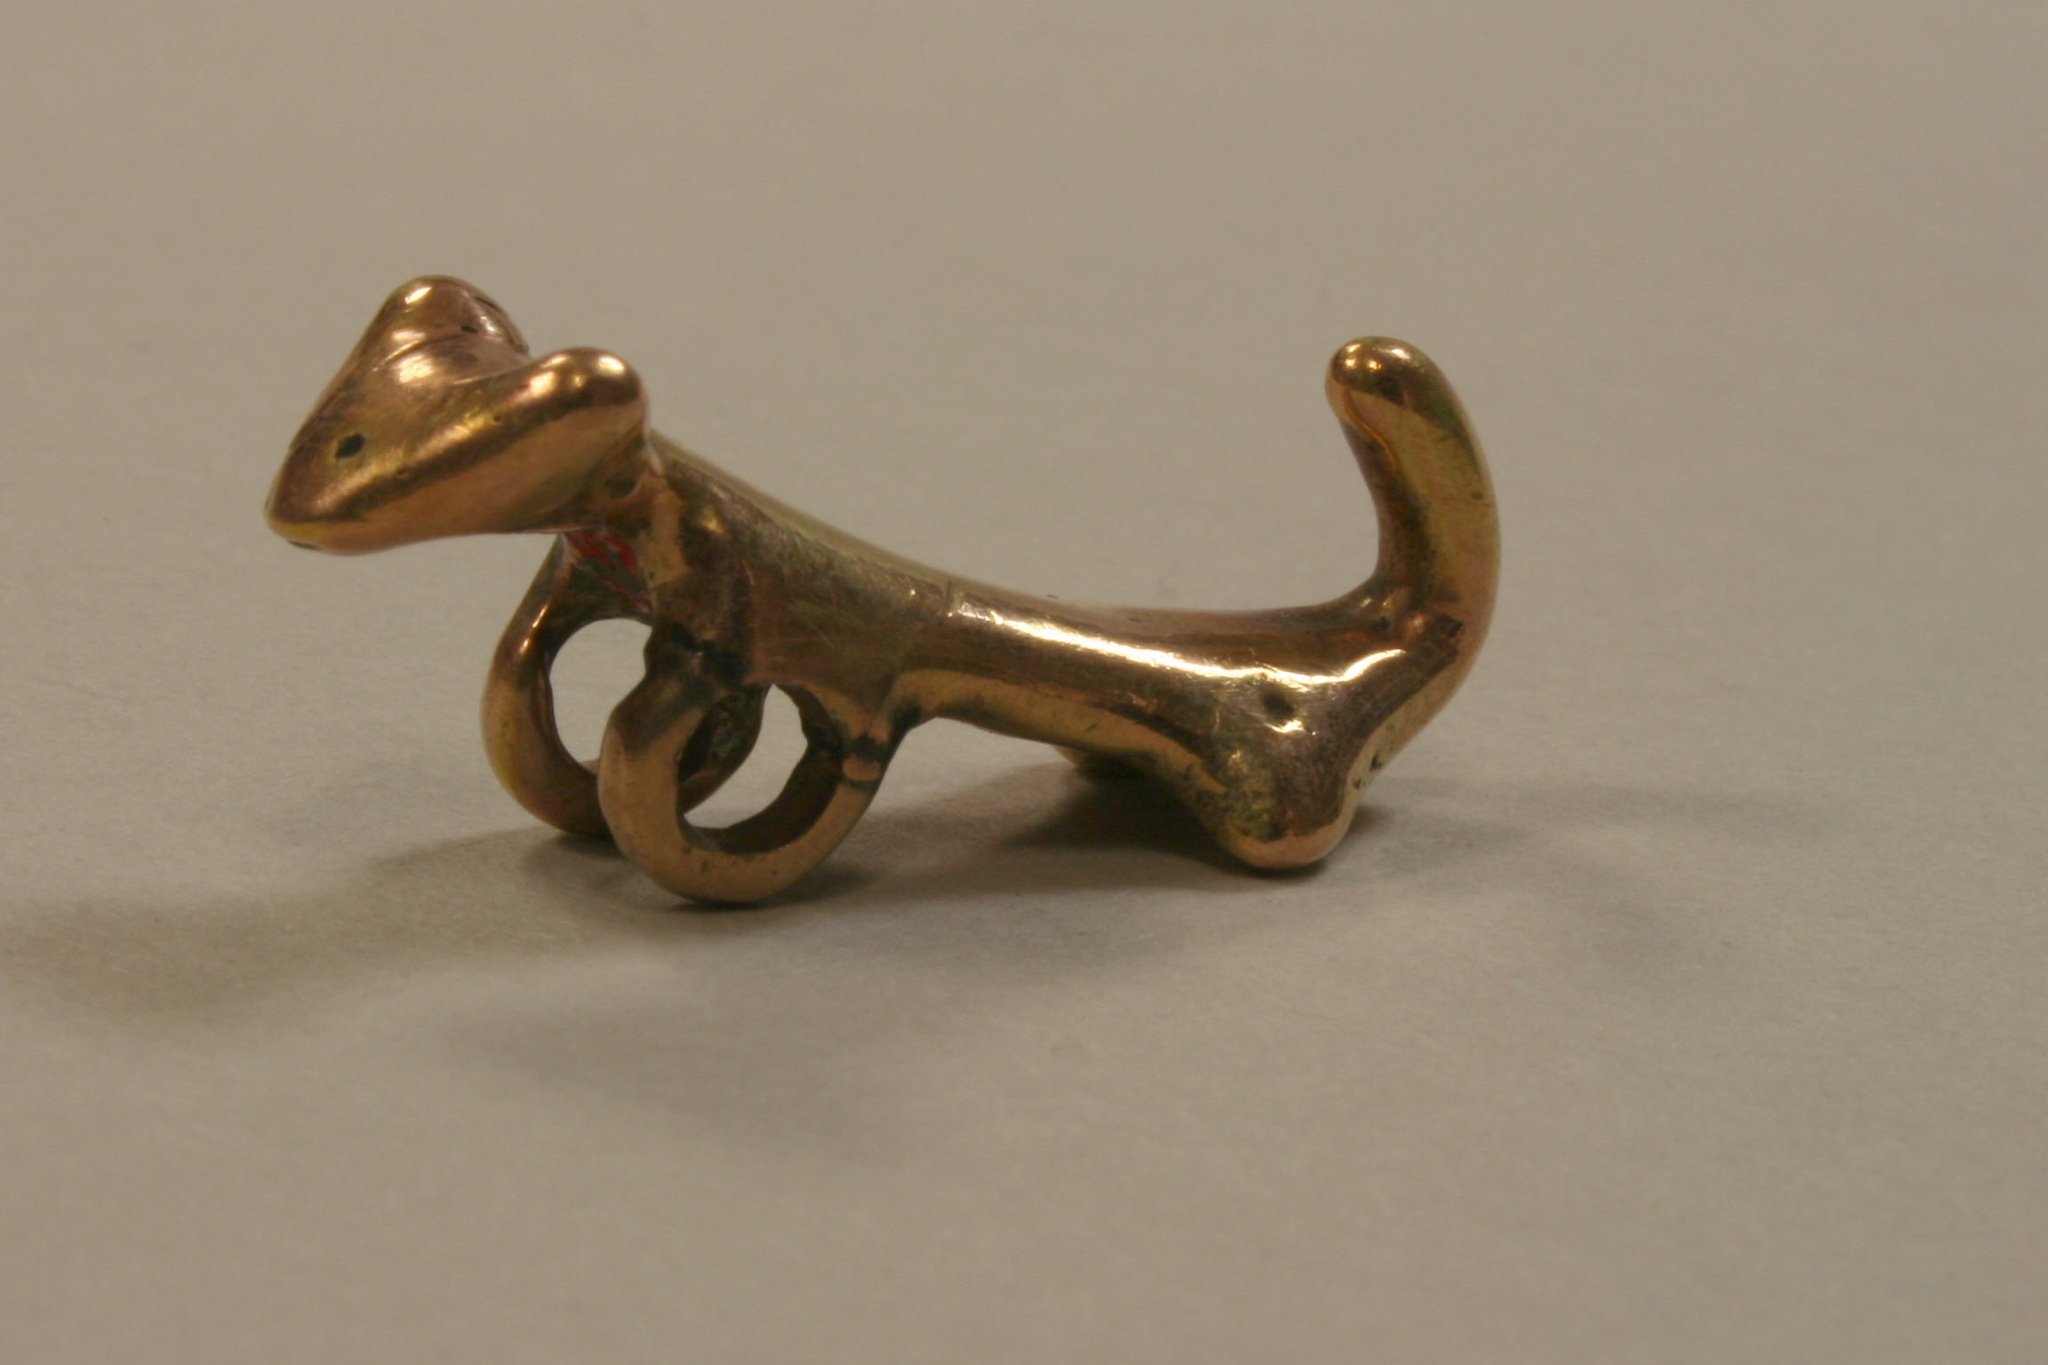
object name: ornament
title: Gold Animal Ornament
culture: veraguas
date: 1001-1600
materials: gold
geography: panama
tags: animals